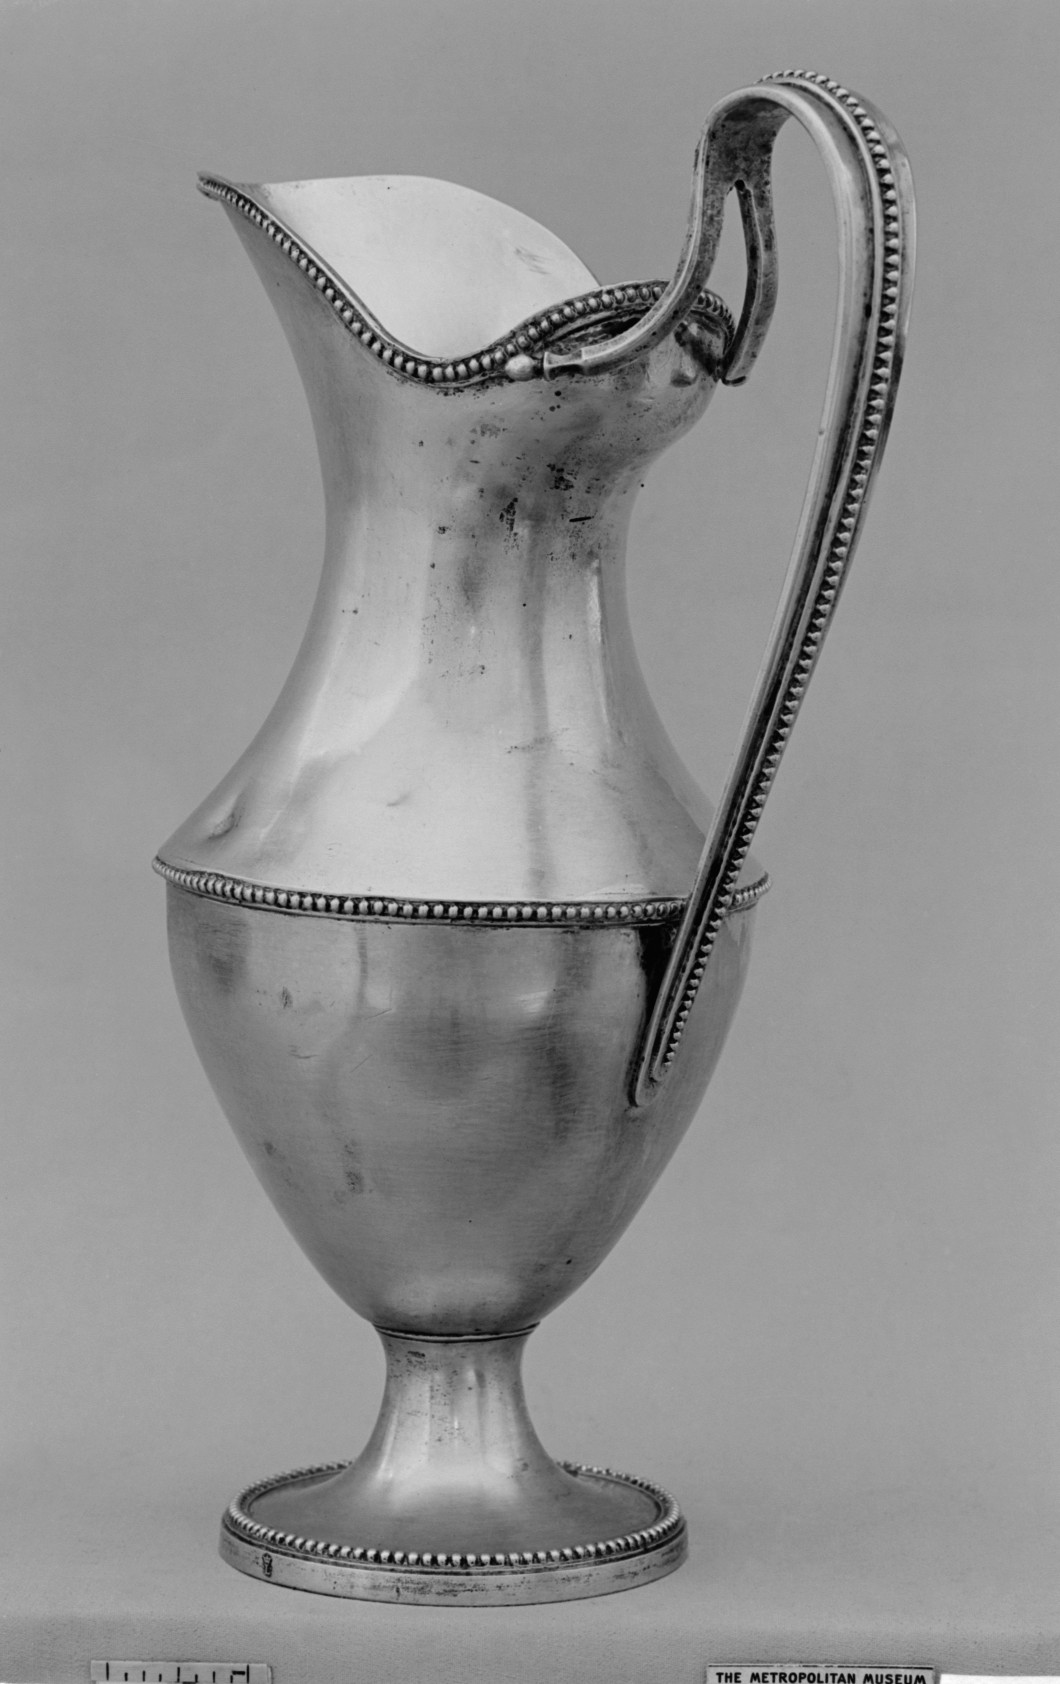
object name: ewer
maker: r. s. j.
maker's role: maker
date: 1776-1800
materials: silver